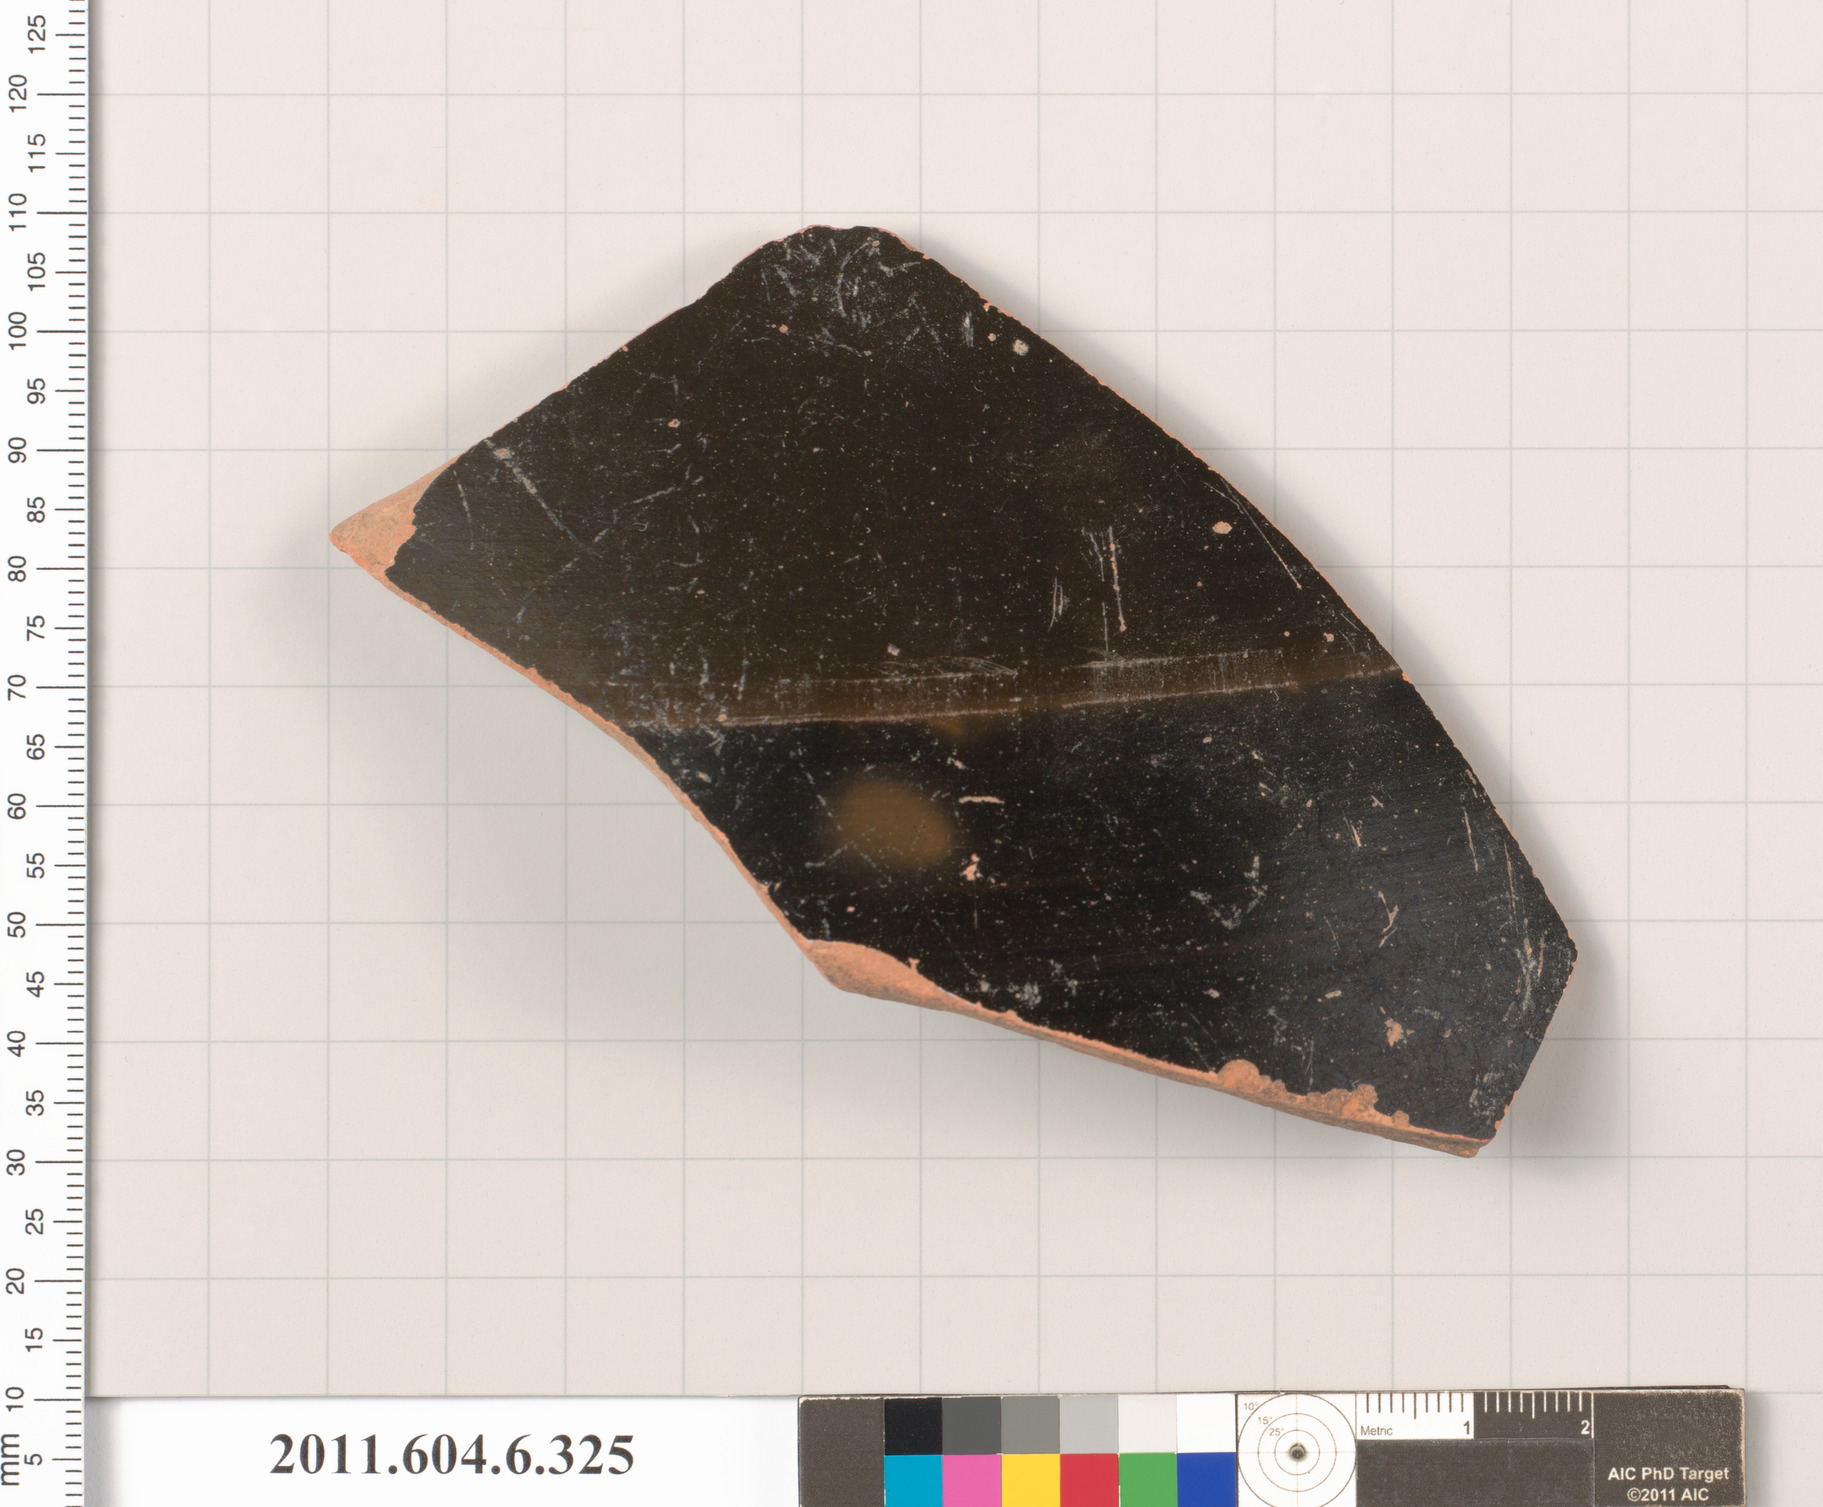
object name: krater fragment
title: Terracotta fragment of a krater (bowl for mixing wine and water)?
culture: greek, attic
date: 600-401 BCE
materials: terracotta